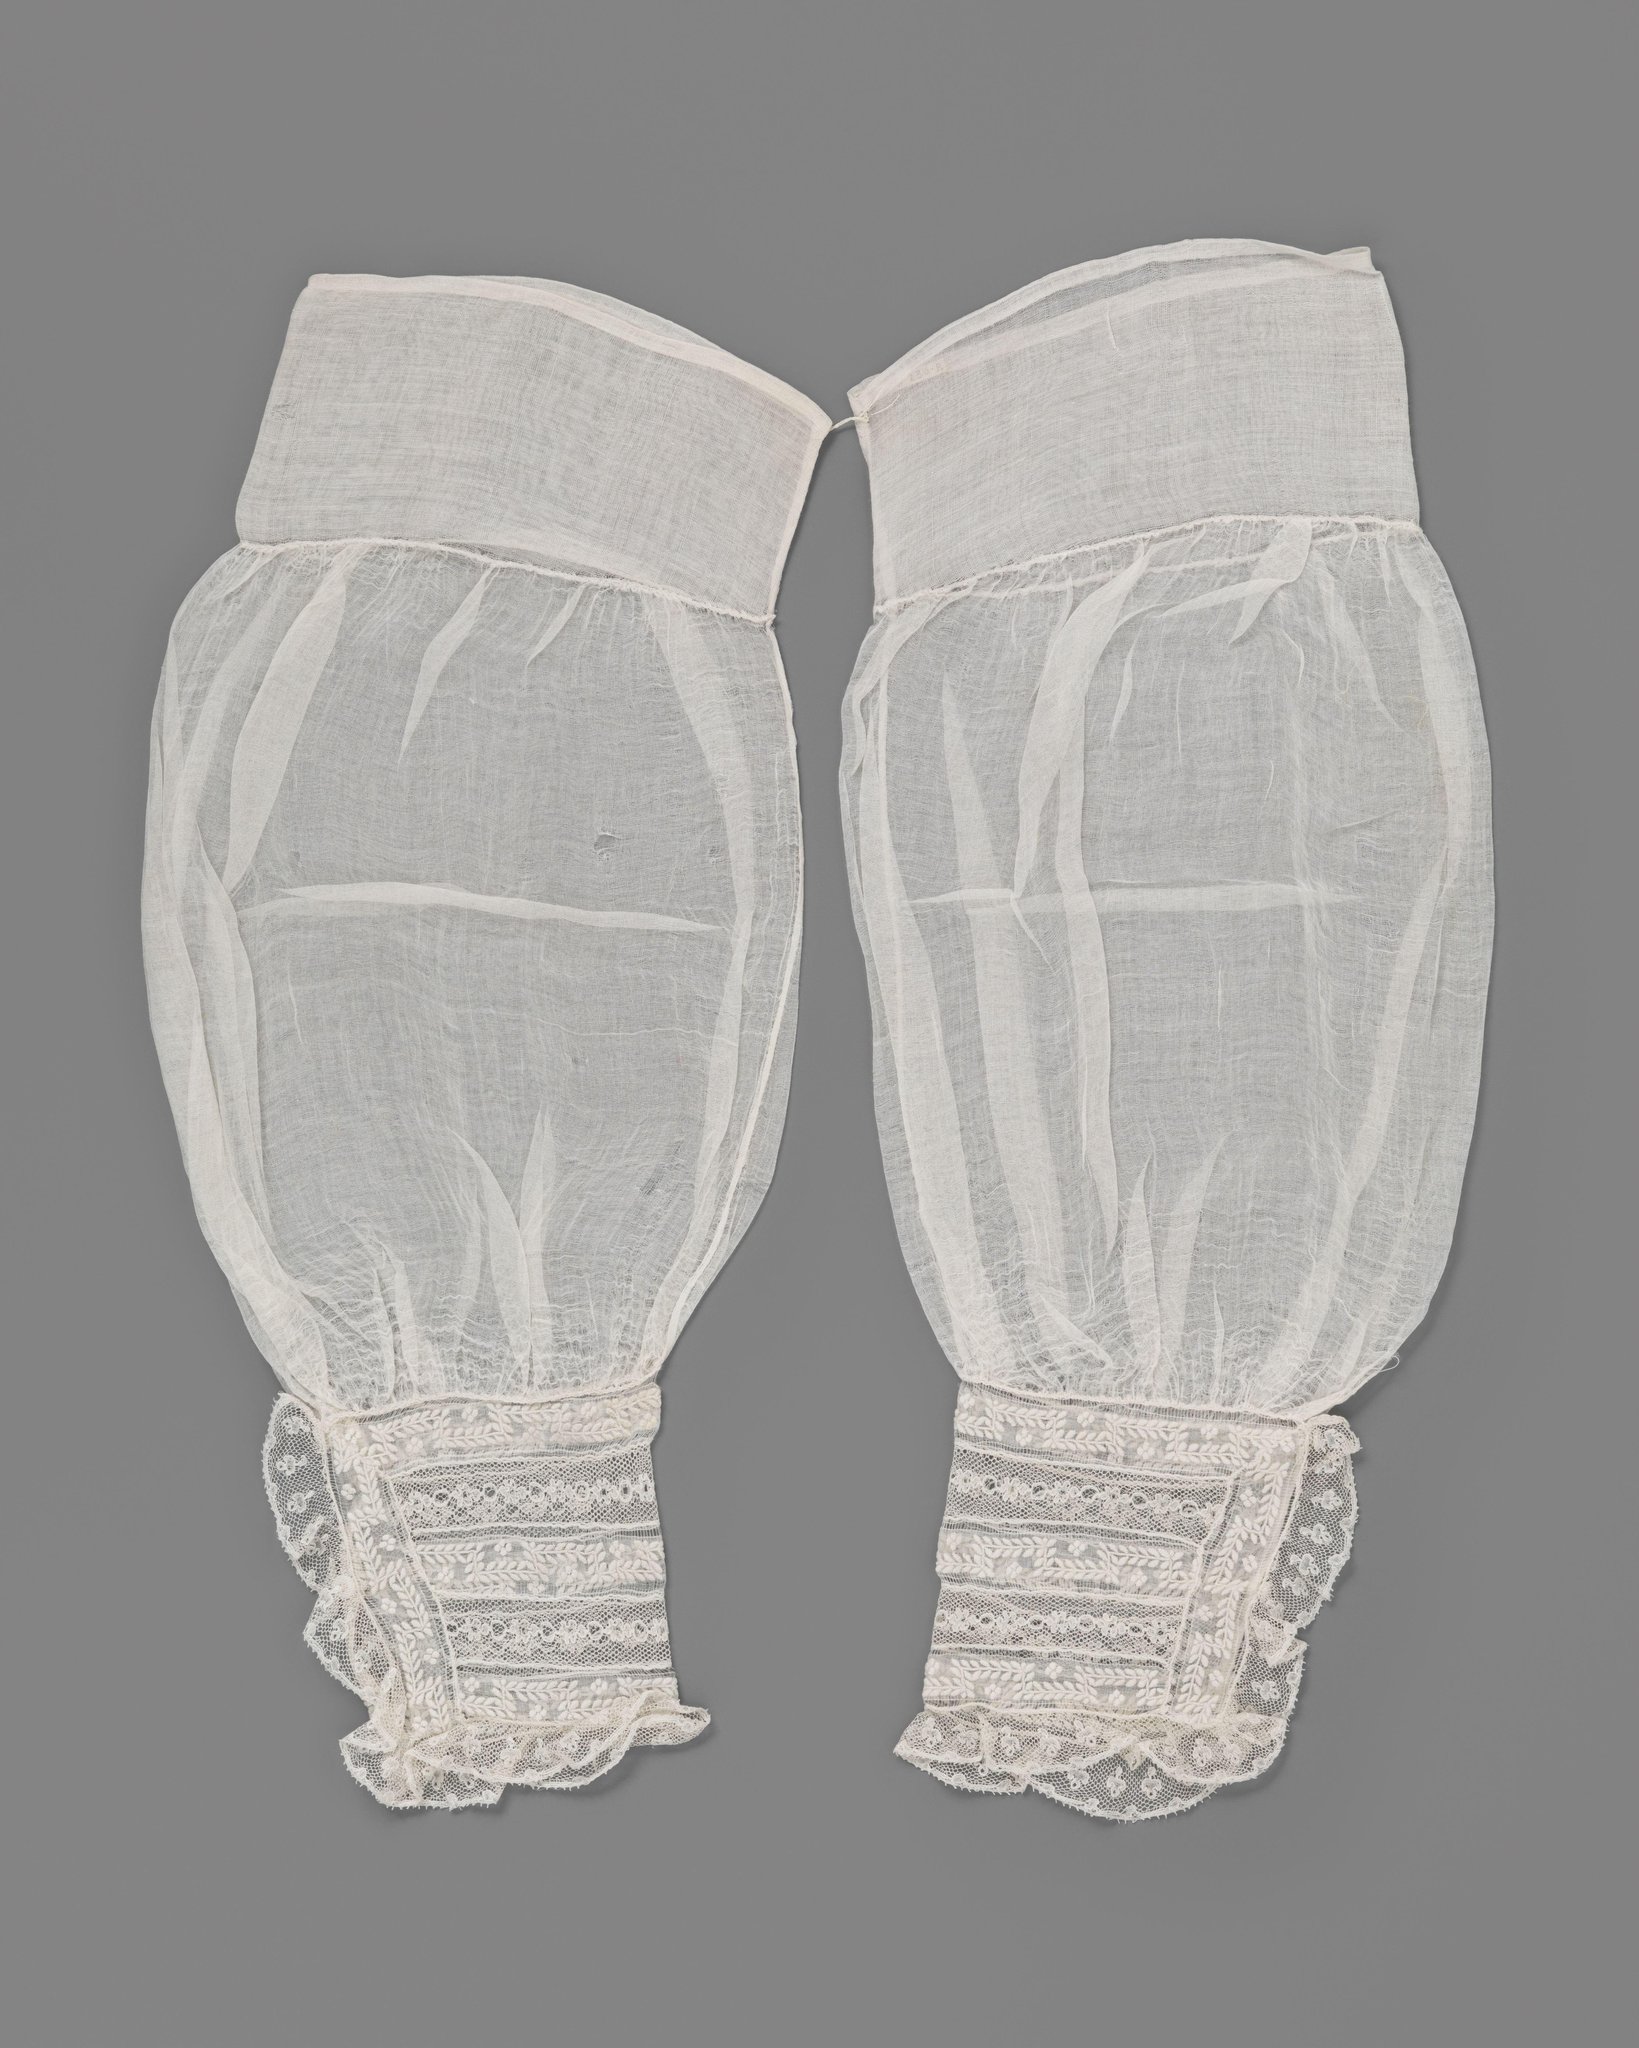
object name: voormouw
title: Voormouw van glasbatist met borduurwerk en kant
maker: Anonymous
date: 1860-1880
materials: textile, glass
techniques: embroidered, lace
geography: western europe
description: Voormouw van glasbatist. De rechte manchet is versierd met drie stroken batist waarop wit borduurwerk in de vorm van bladeren, en twee tussenzetsels van Rijsselse kloskant. De manchet is afgezet met een Mechelse kant. De sluiting bestaat uit drie witglazen knopen.